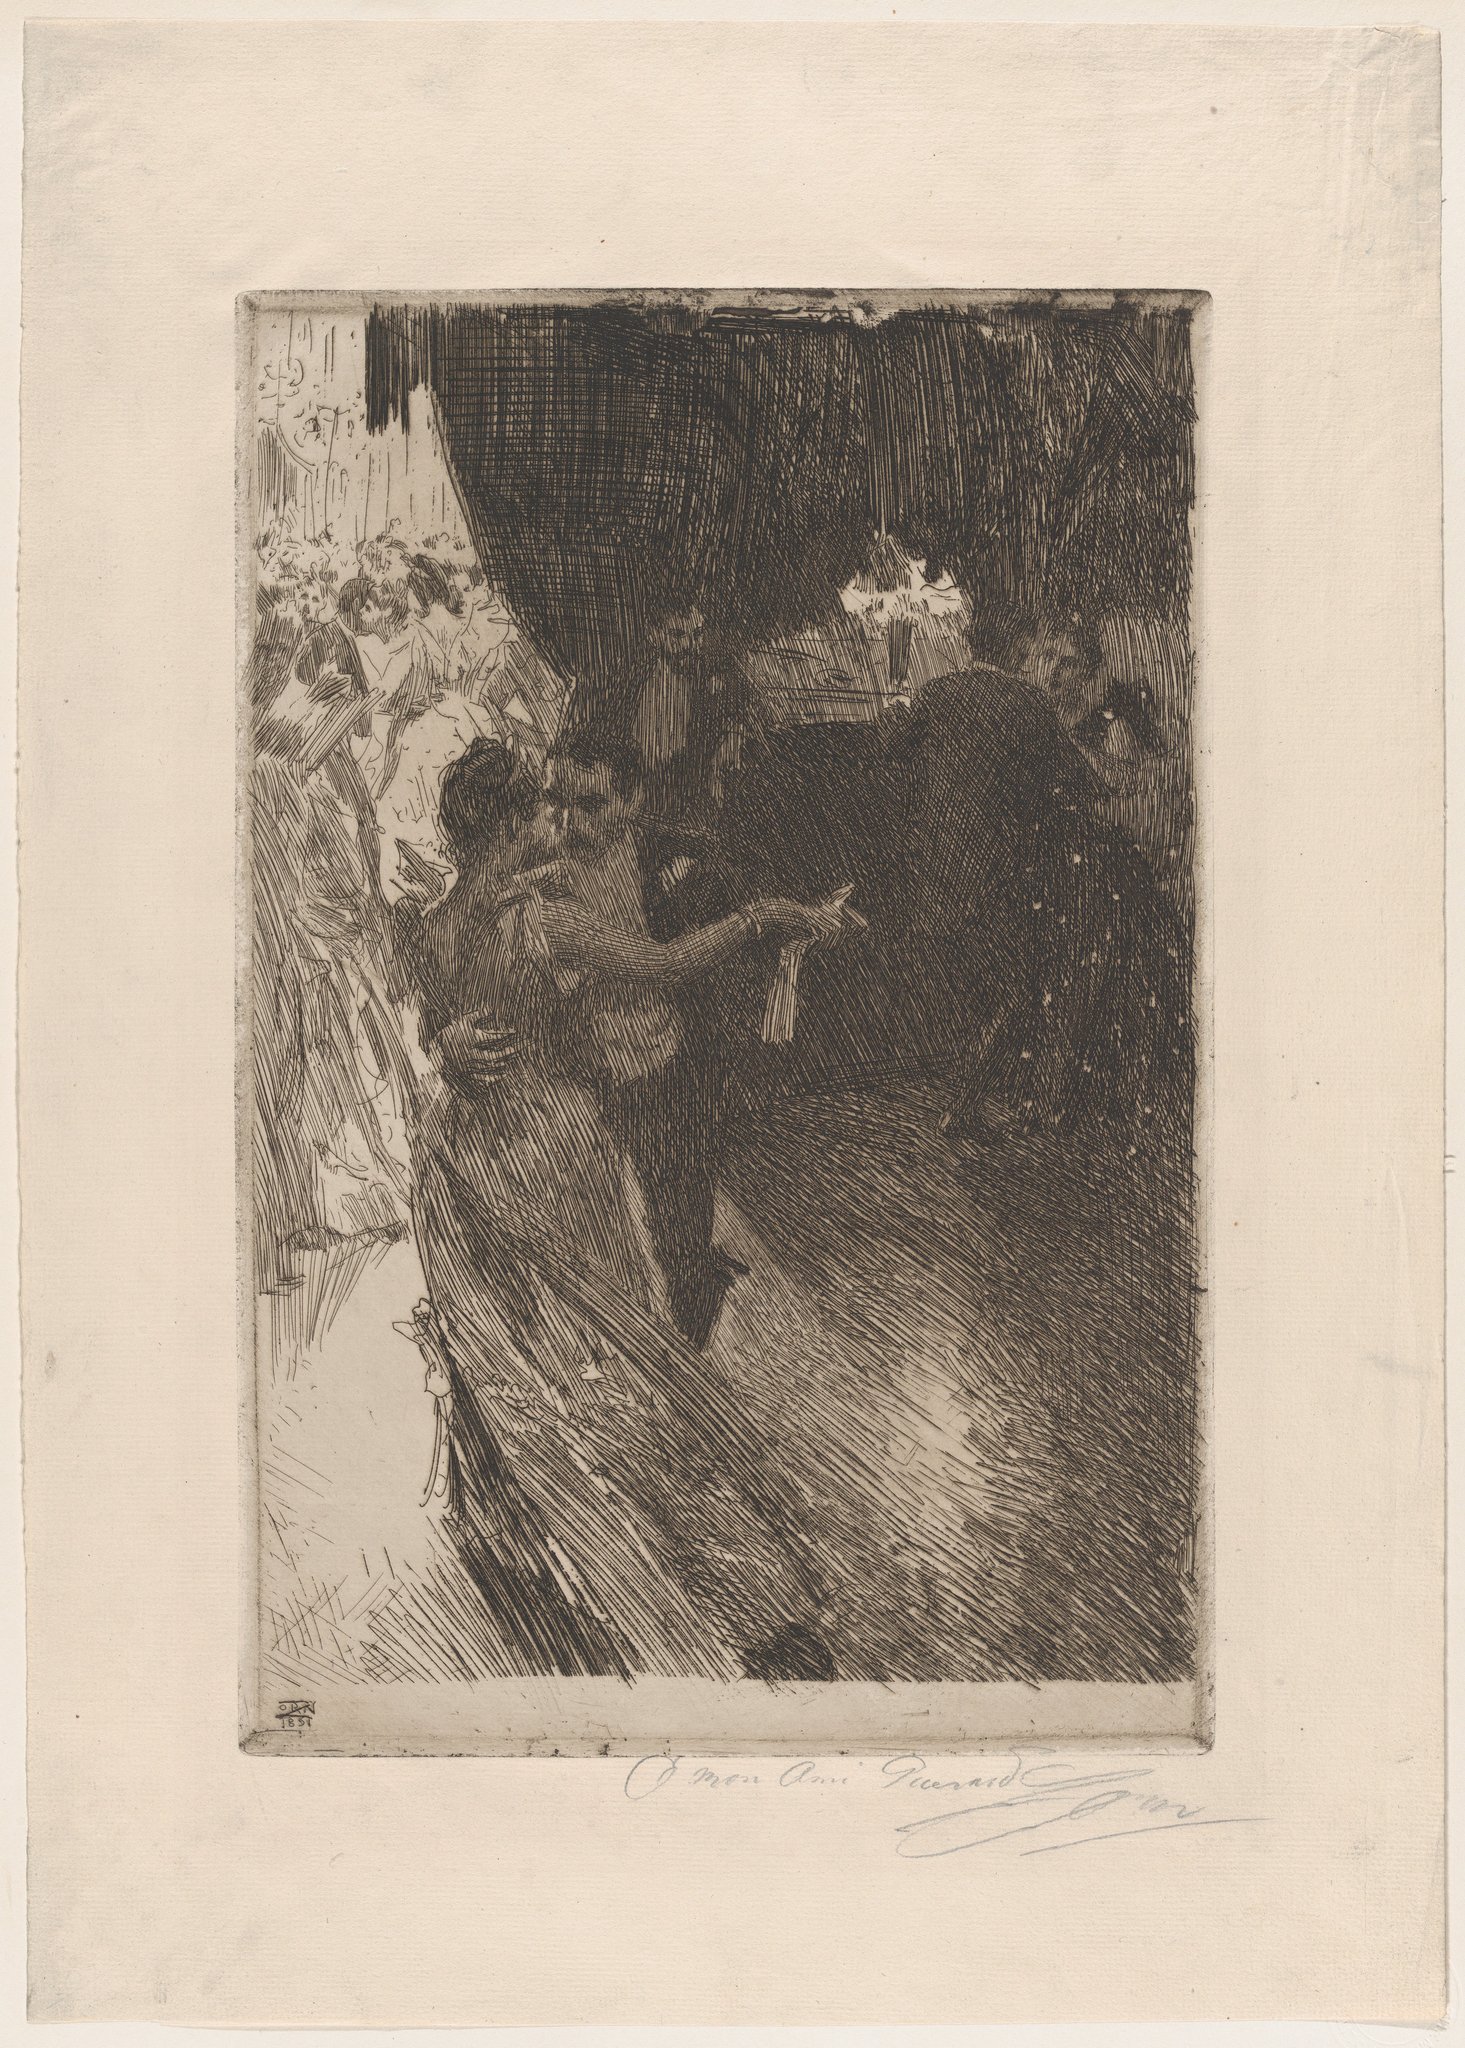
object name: print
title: The Waltz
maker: anders zorn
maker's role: artist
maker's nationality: swedish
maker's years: 1860-1920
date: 1891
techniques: etching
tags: men,women,dancing